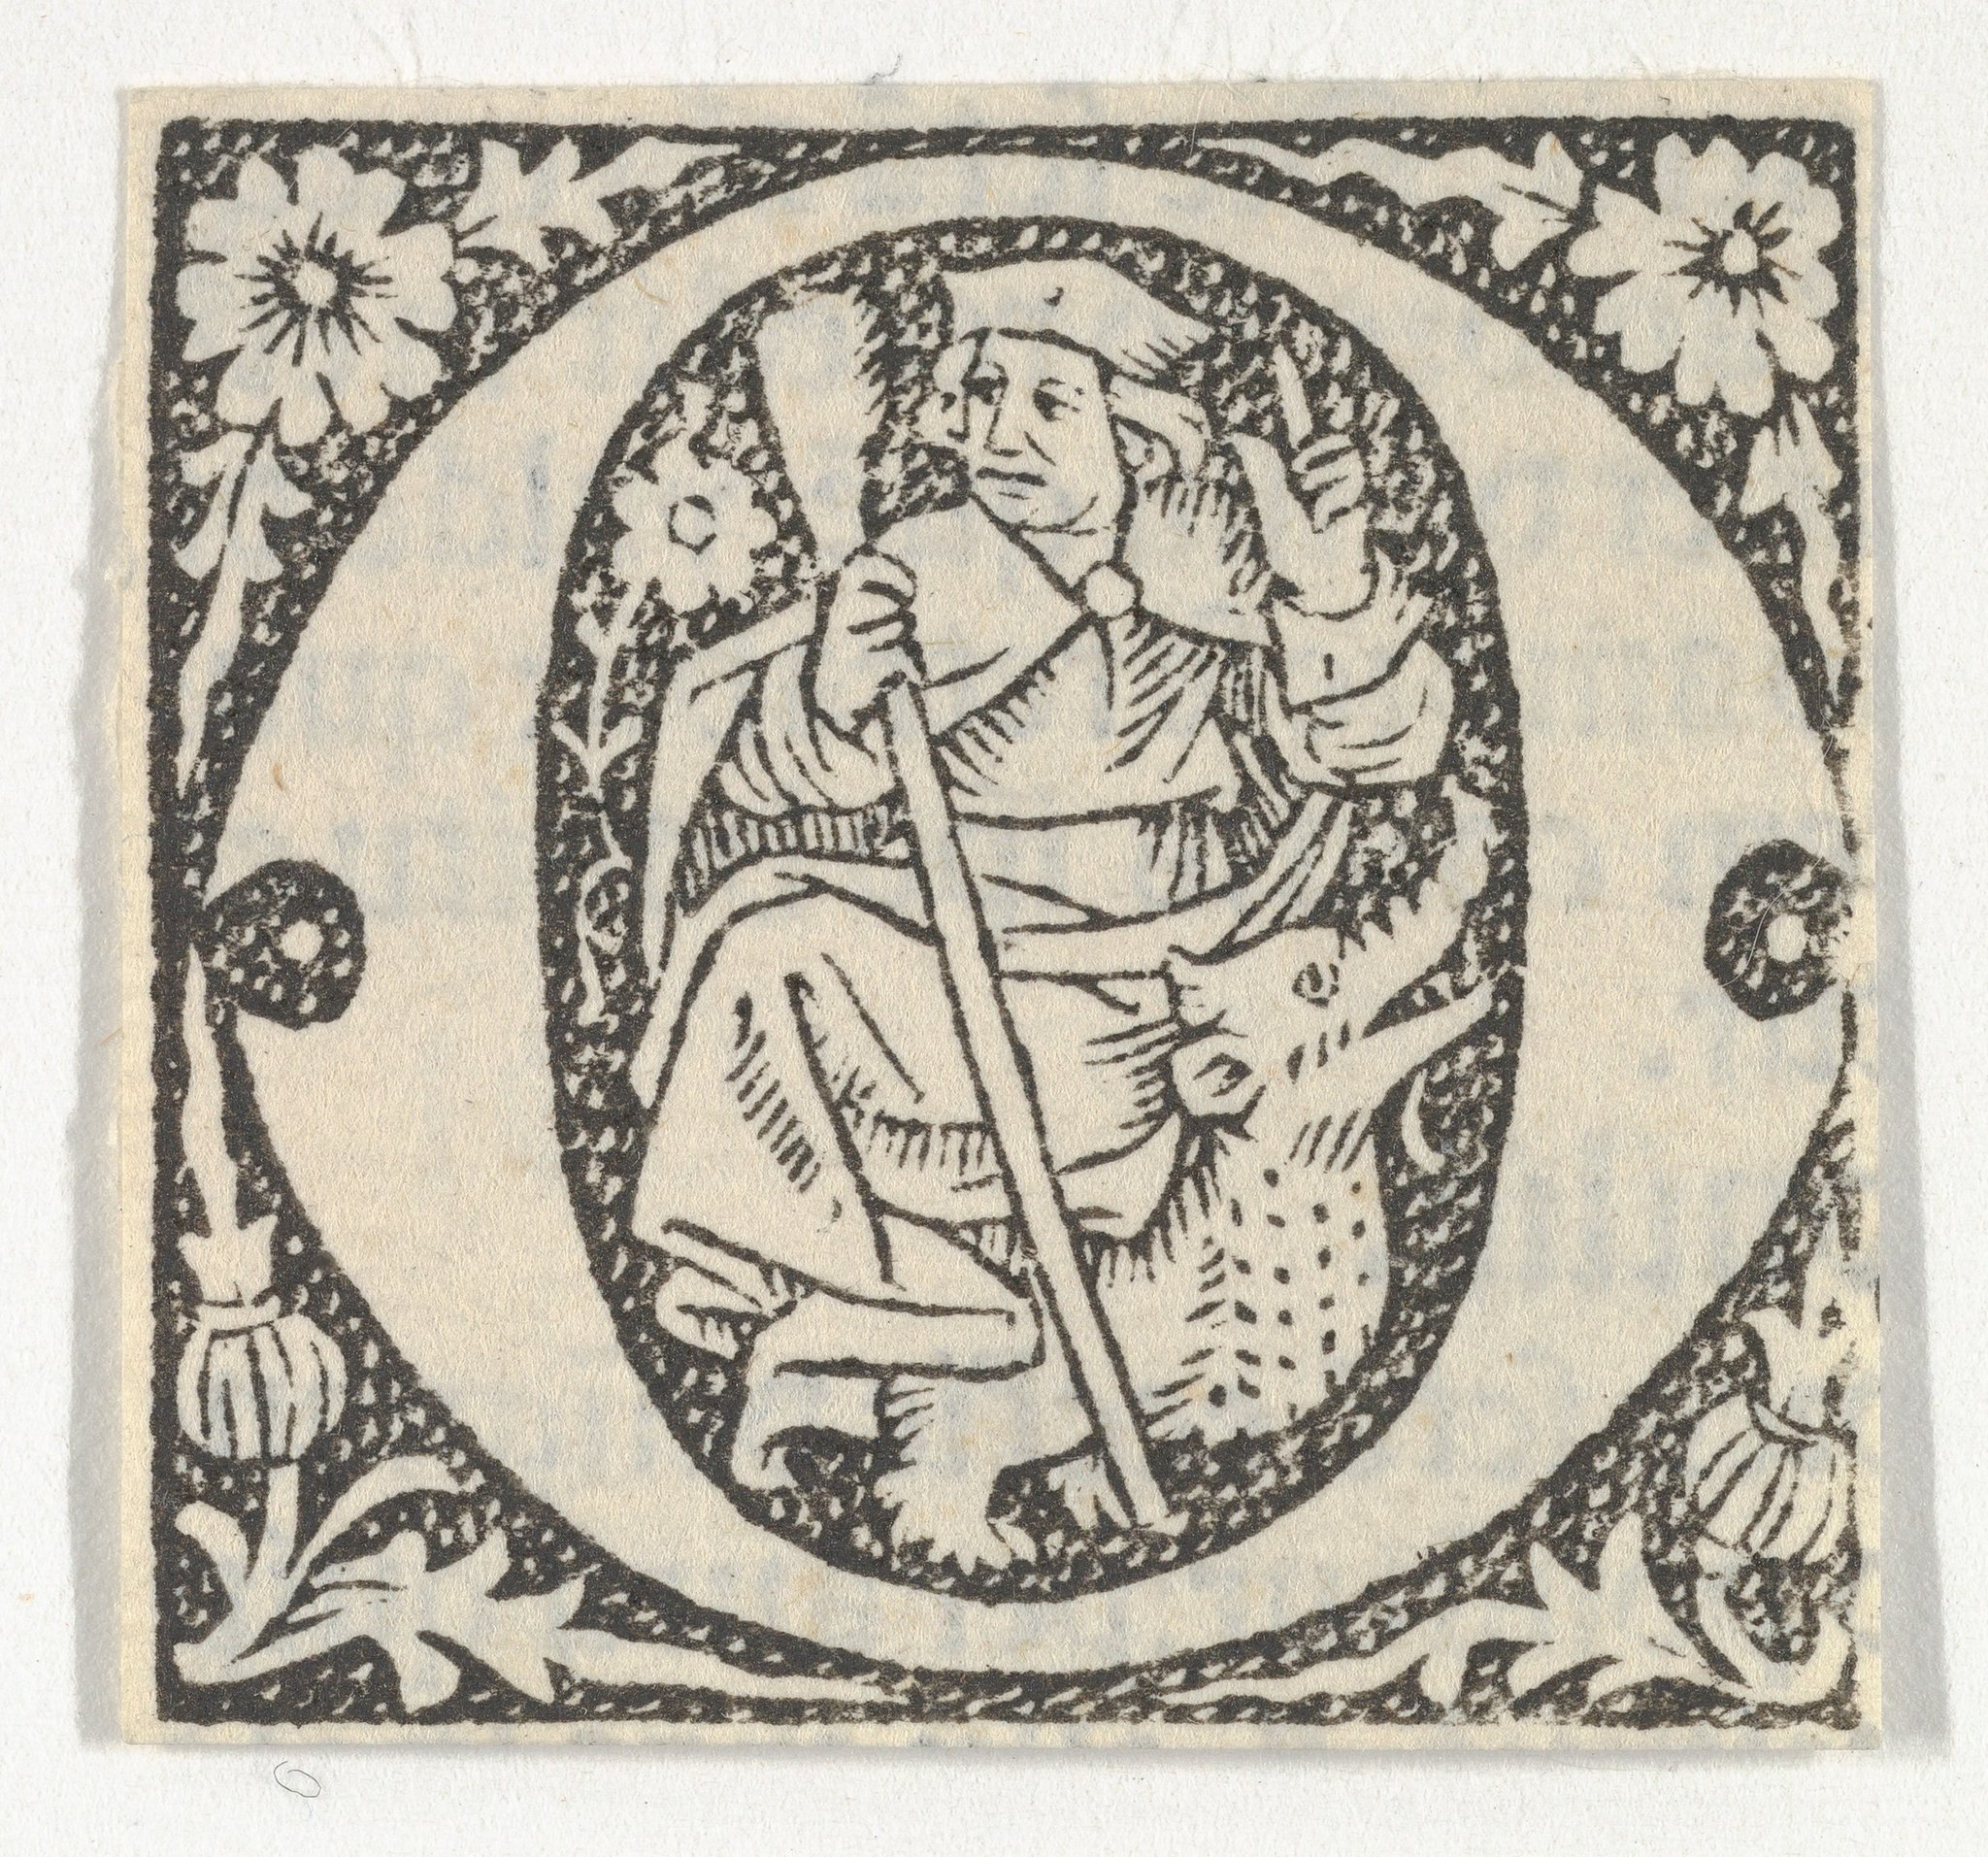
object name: print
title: Decorated Roman alphabet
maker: anonymous, french, 15th century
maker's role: artist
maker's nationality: french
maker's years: 1400-1500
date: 1499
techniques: woodcut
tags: men,portraits,crocodiles